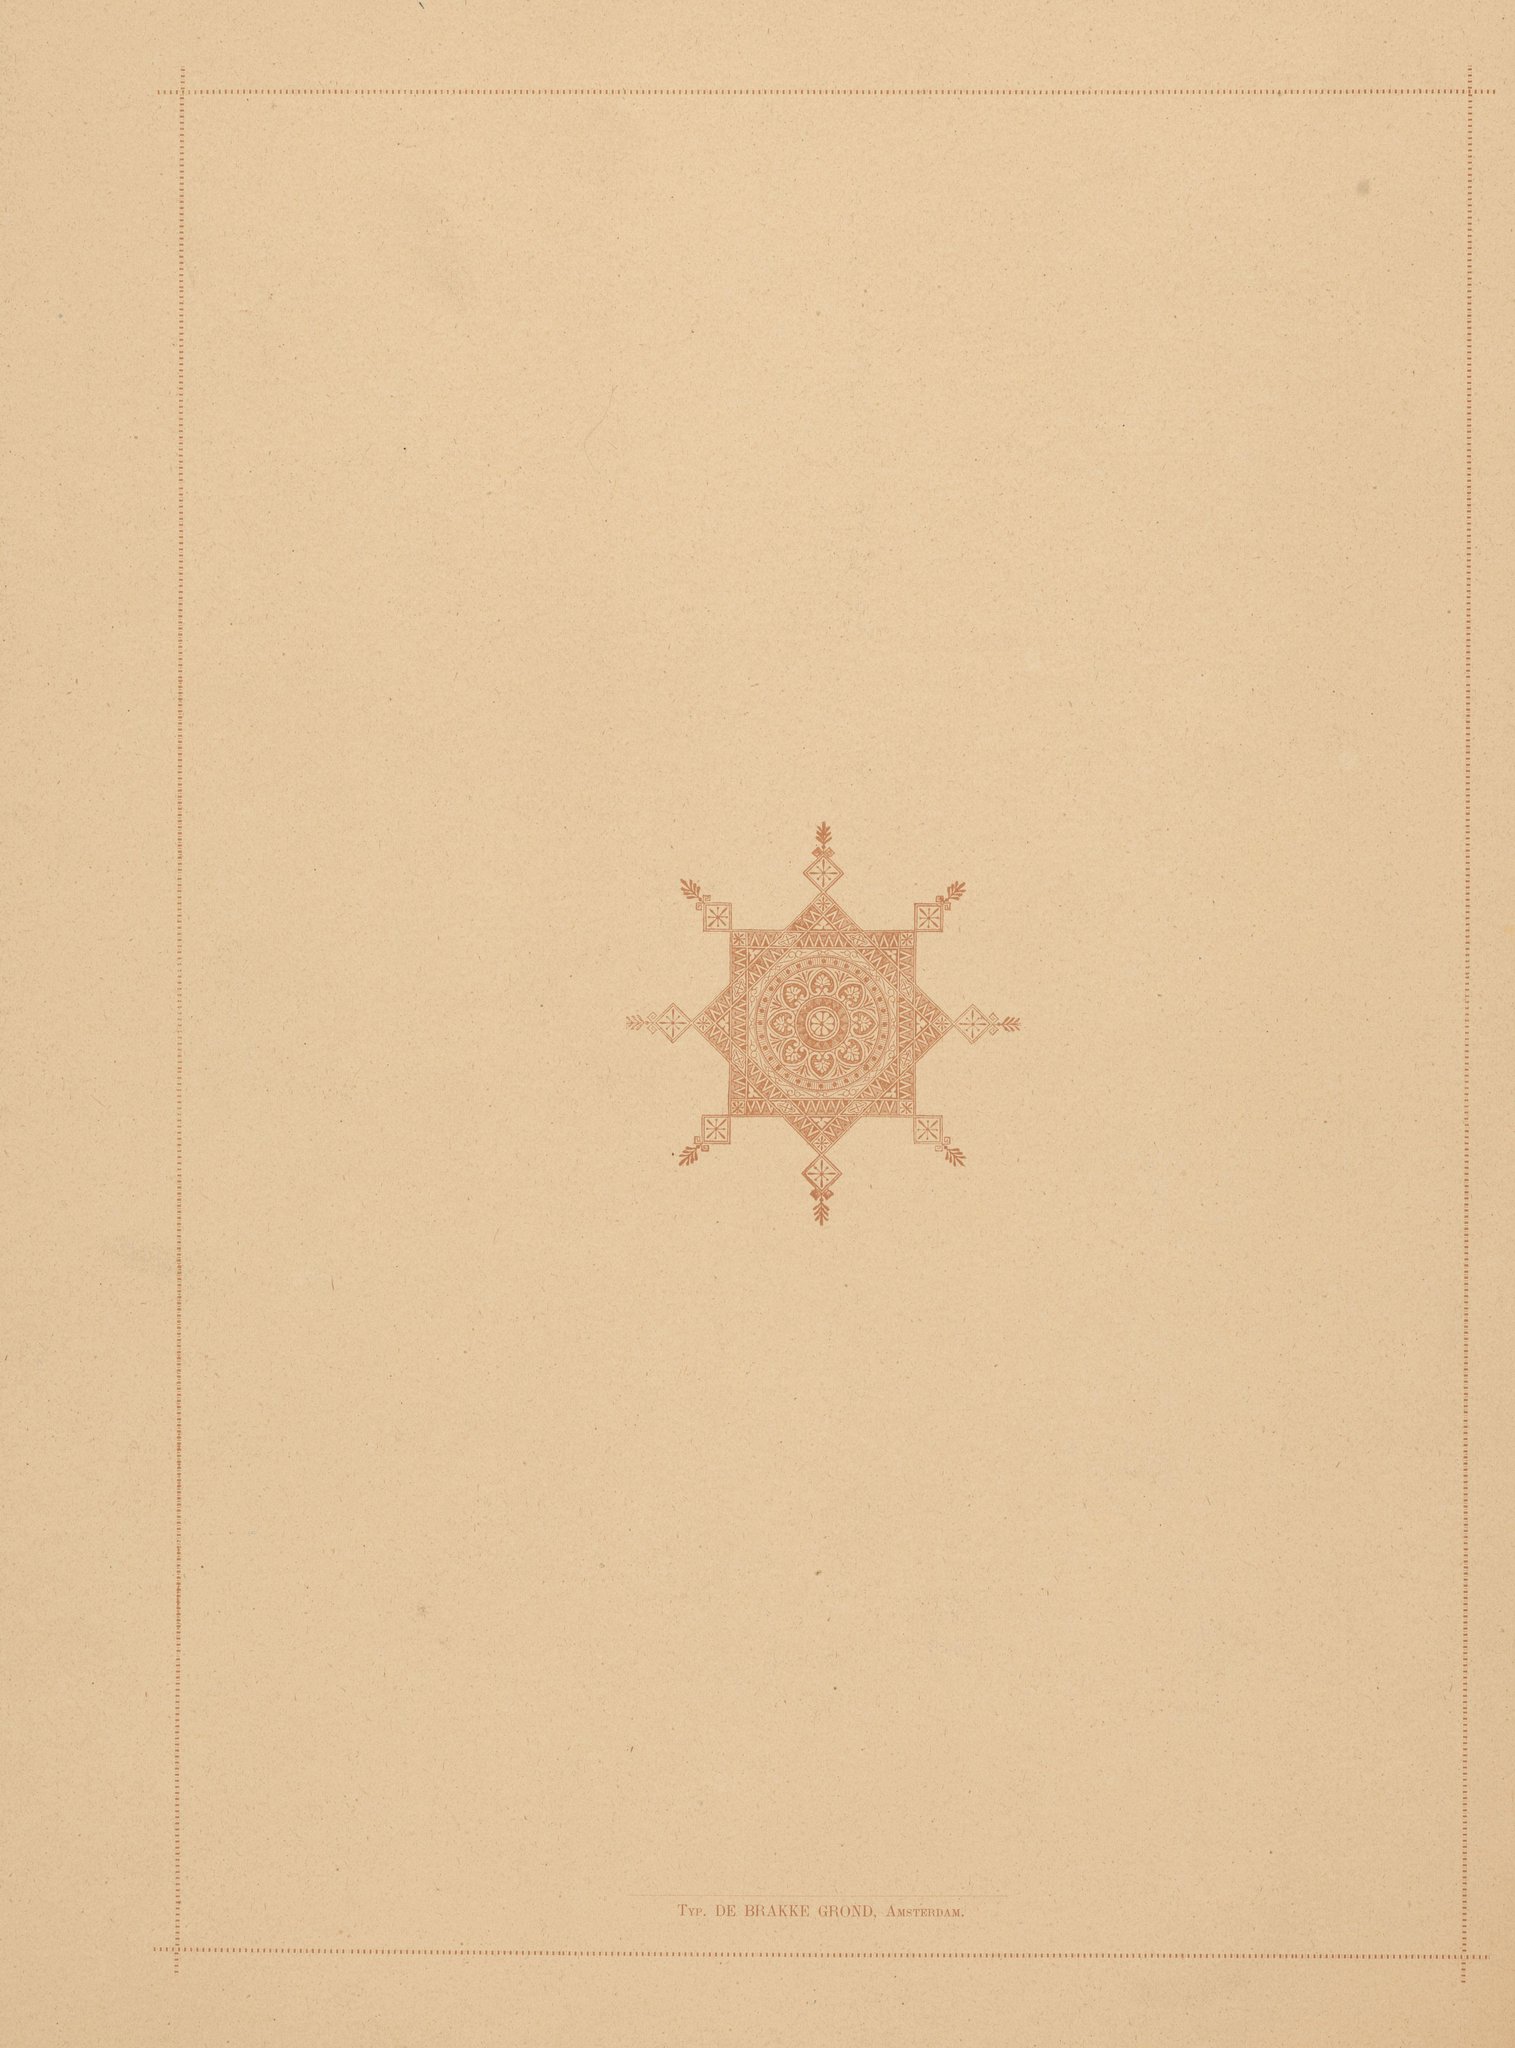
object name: print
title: 1826-1896. Generaal van der Heijden-Album. Uitgegeven ter gelegenheid van den 70sten verjaardag van (...) Karel van der Heijden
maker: Anonymous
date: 1896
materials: paper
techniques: lithograph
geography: netherlands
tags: dutch east indies, the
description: Binnenomslag met een gezicht op de kraton. Voor een blad van zestien bladzijden met tekst. Album uitgegeven ter gelegenheid van de zeventigste verjaardag van luitenant-generaal Karel van der Heijden, 1896. Uitgave van de Amsterdamsche Courant.